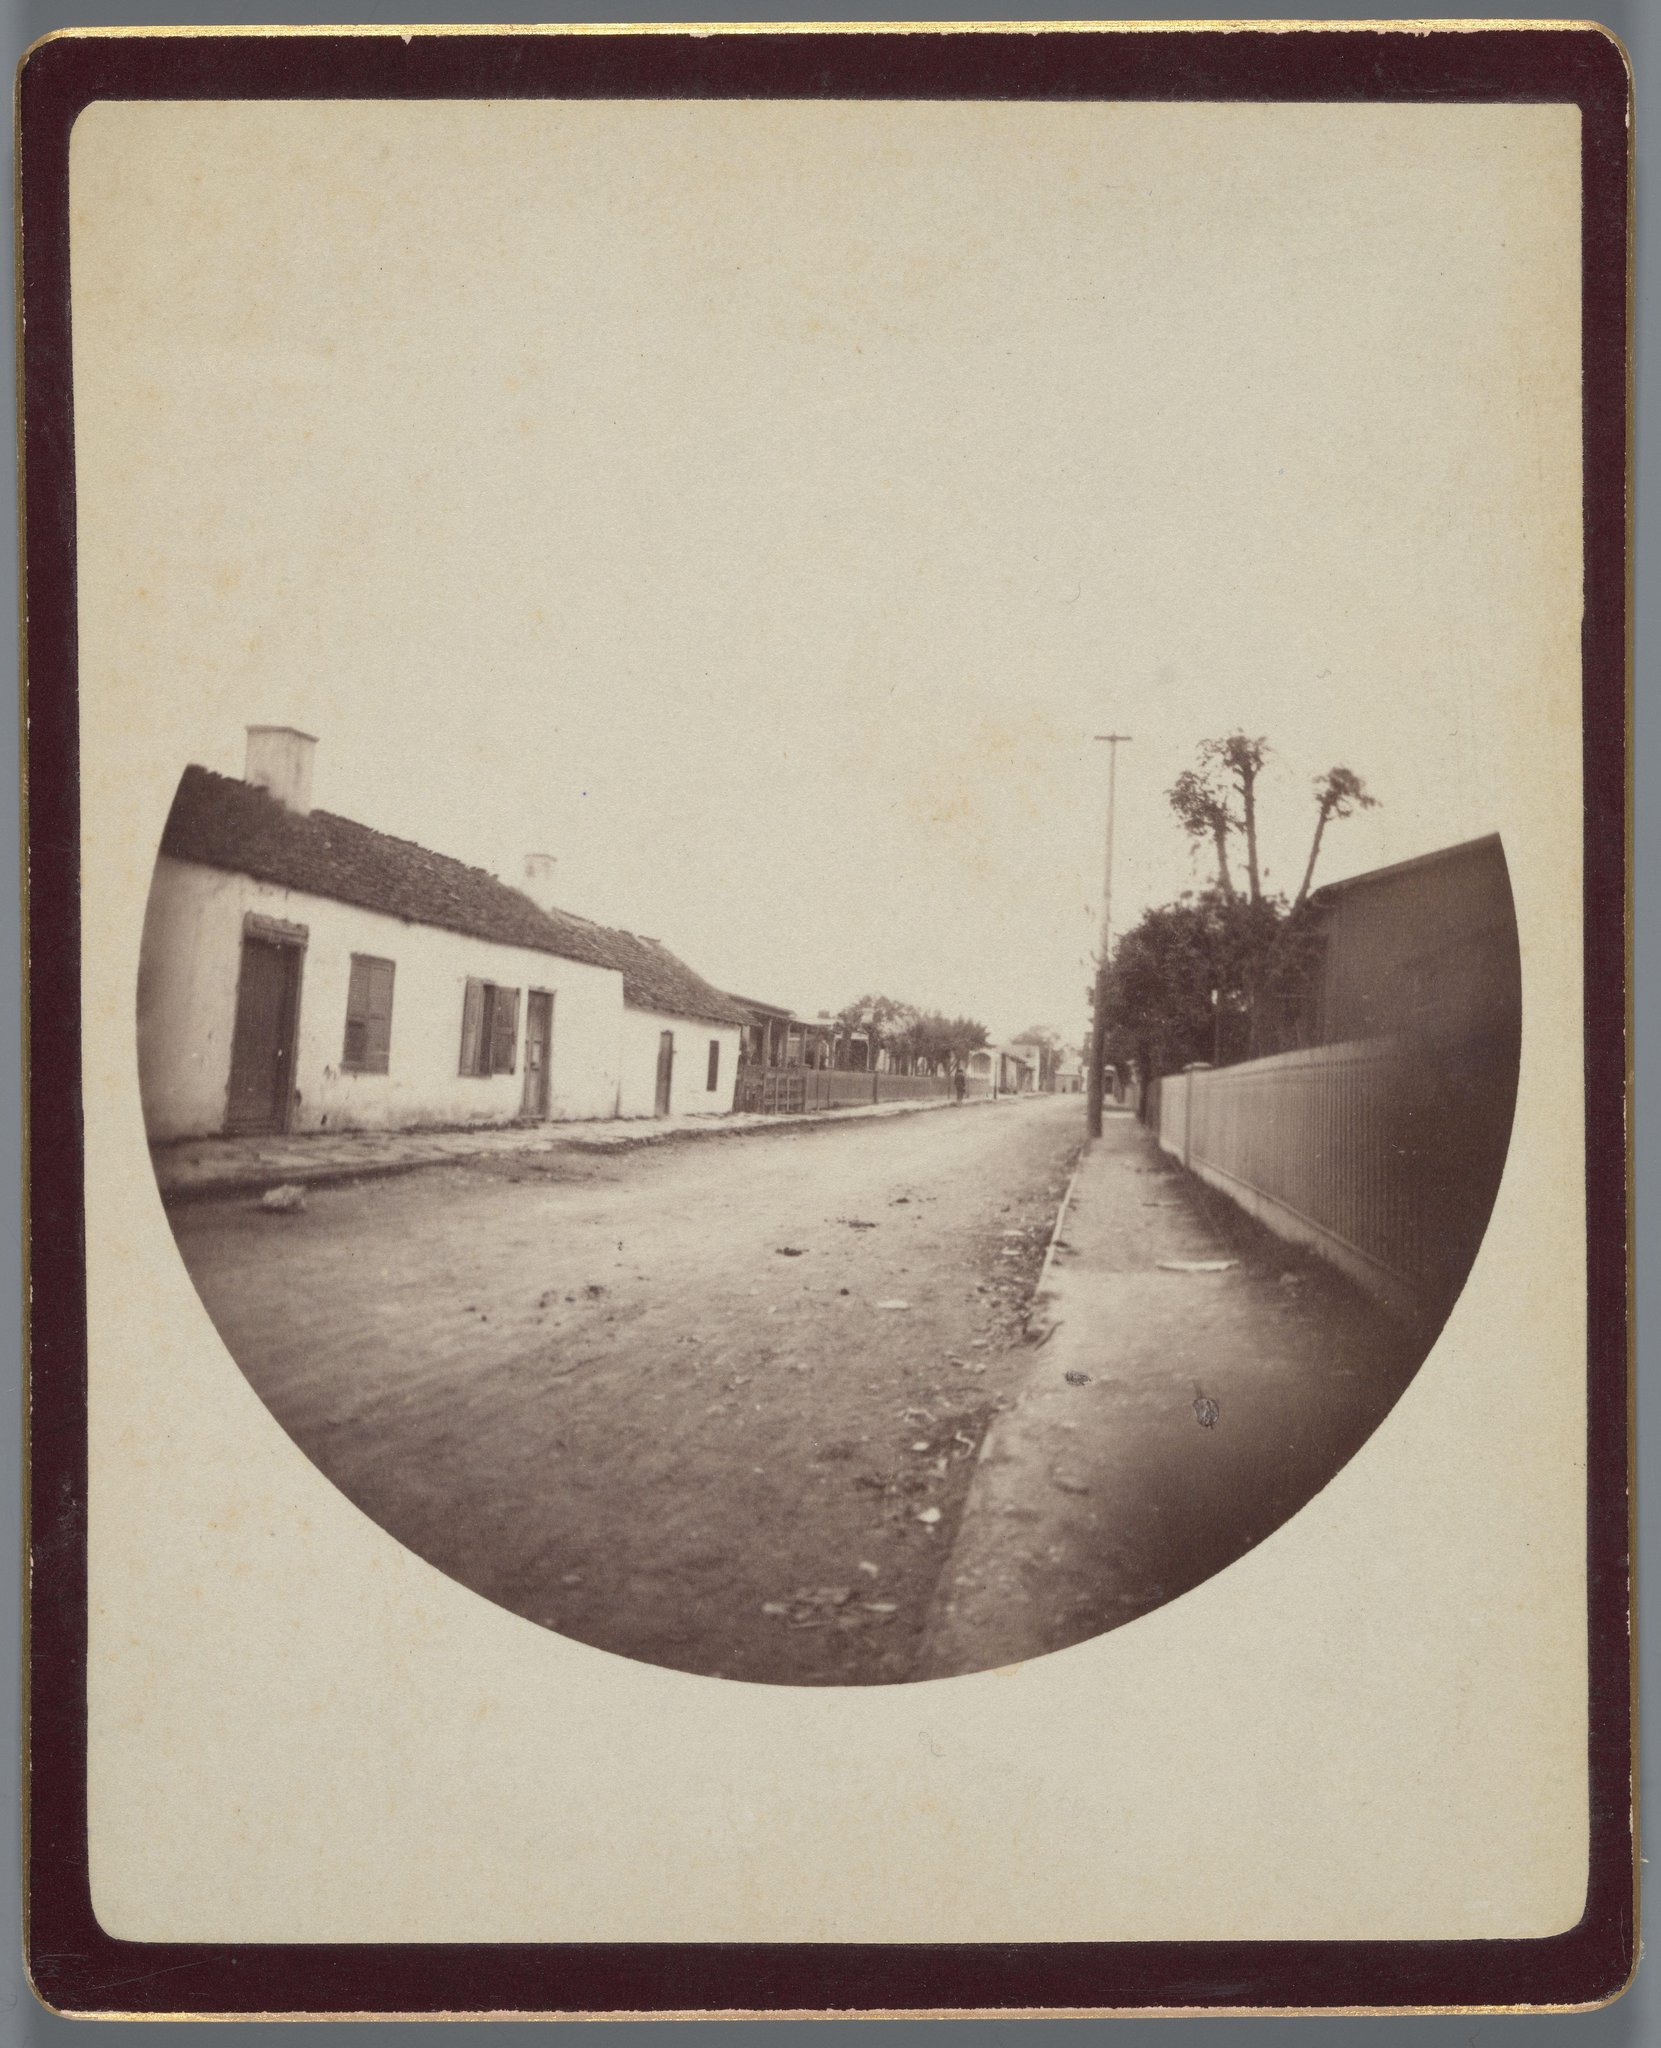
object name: photograph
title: Aanleg Central Mexican Railway april 1890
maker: Anonymous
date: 1804-1890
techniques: photography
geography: united states